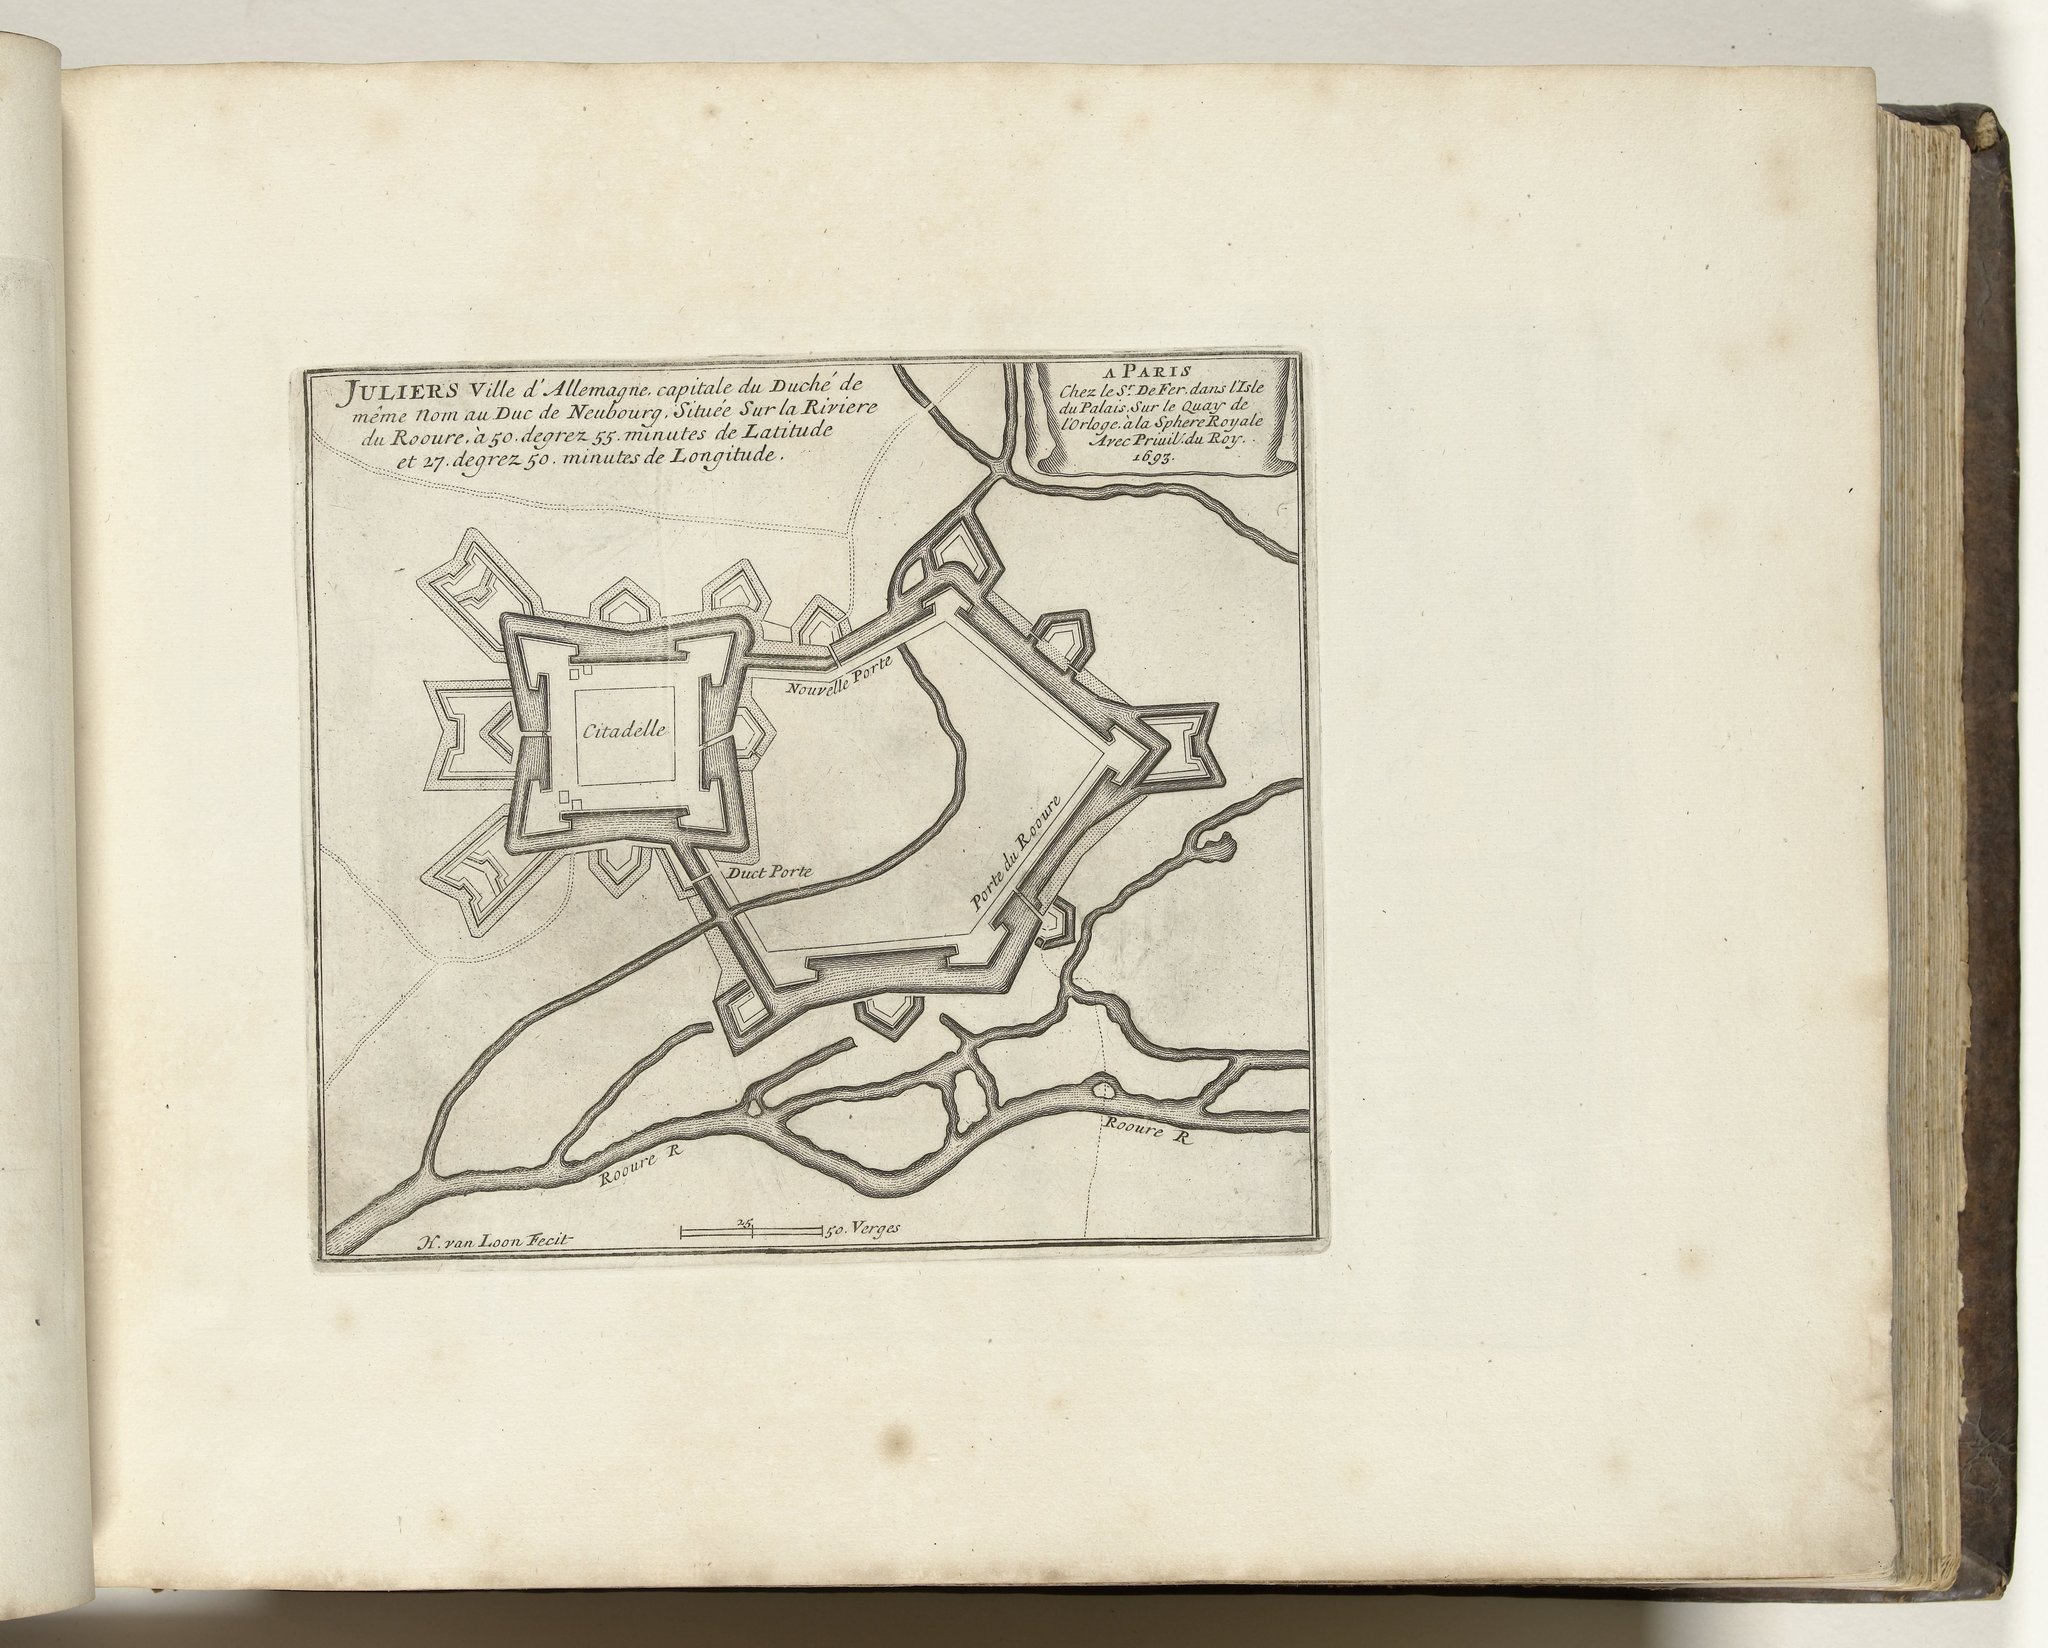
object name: print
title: Plattegrond van Jülich, 1693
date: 1693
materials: paper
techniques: etching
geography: paris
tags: fortress, maps of cities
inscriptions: date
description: Plattegrond van de versterkingen om de Duitse stad Jülich (Gulik). Onderdeel van het tweede deel (1693) van het prentwerk waarin gebundeld zijn de acht delen van Les forces de l'Europe uitgegeven tussen 1693-1697. Het prentwerk bestaat uit 175 platen met plannen (afkomstig van Sébastien Le Prestre, Seigneur de Vauban) van vermaarde sterke steden en vestingen in de Negenjarige Oorlog. Titel en opschriften in het Frans.